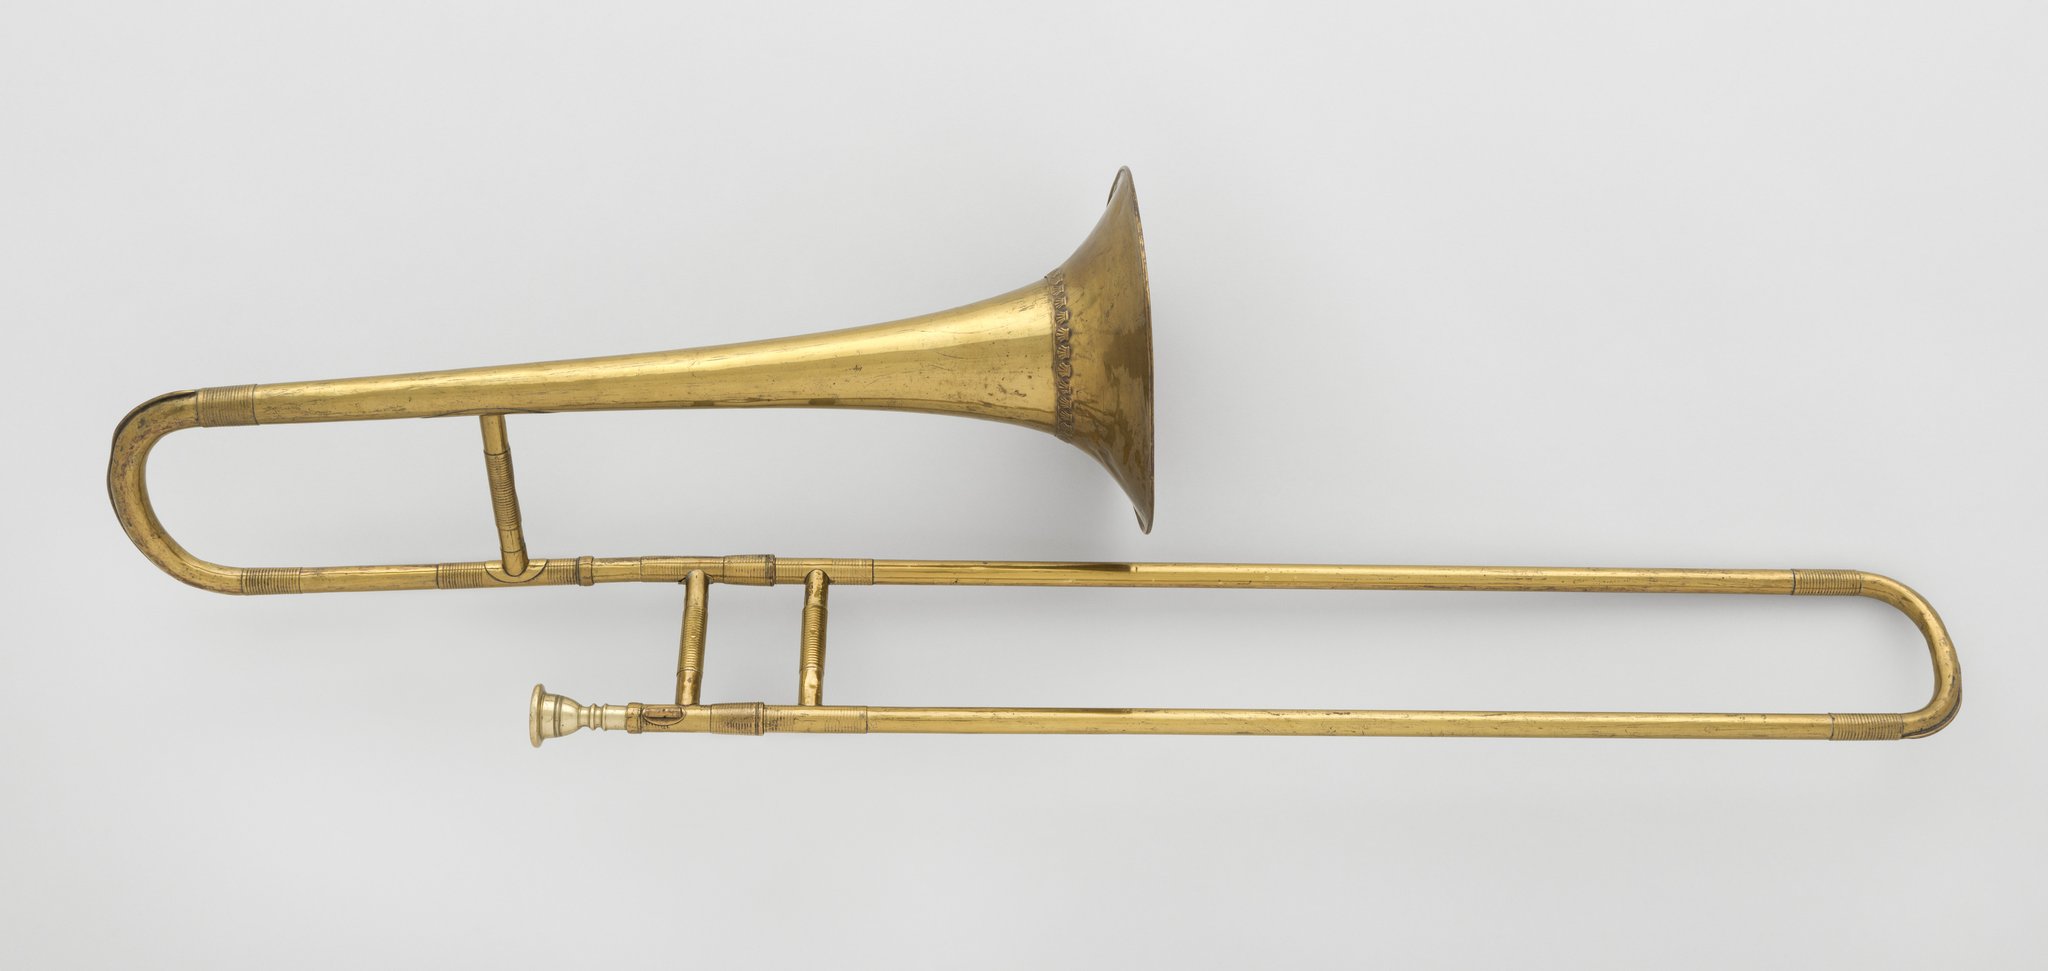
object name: trombone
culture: european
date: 1834-1866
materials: brass